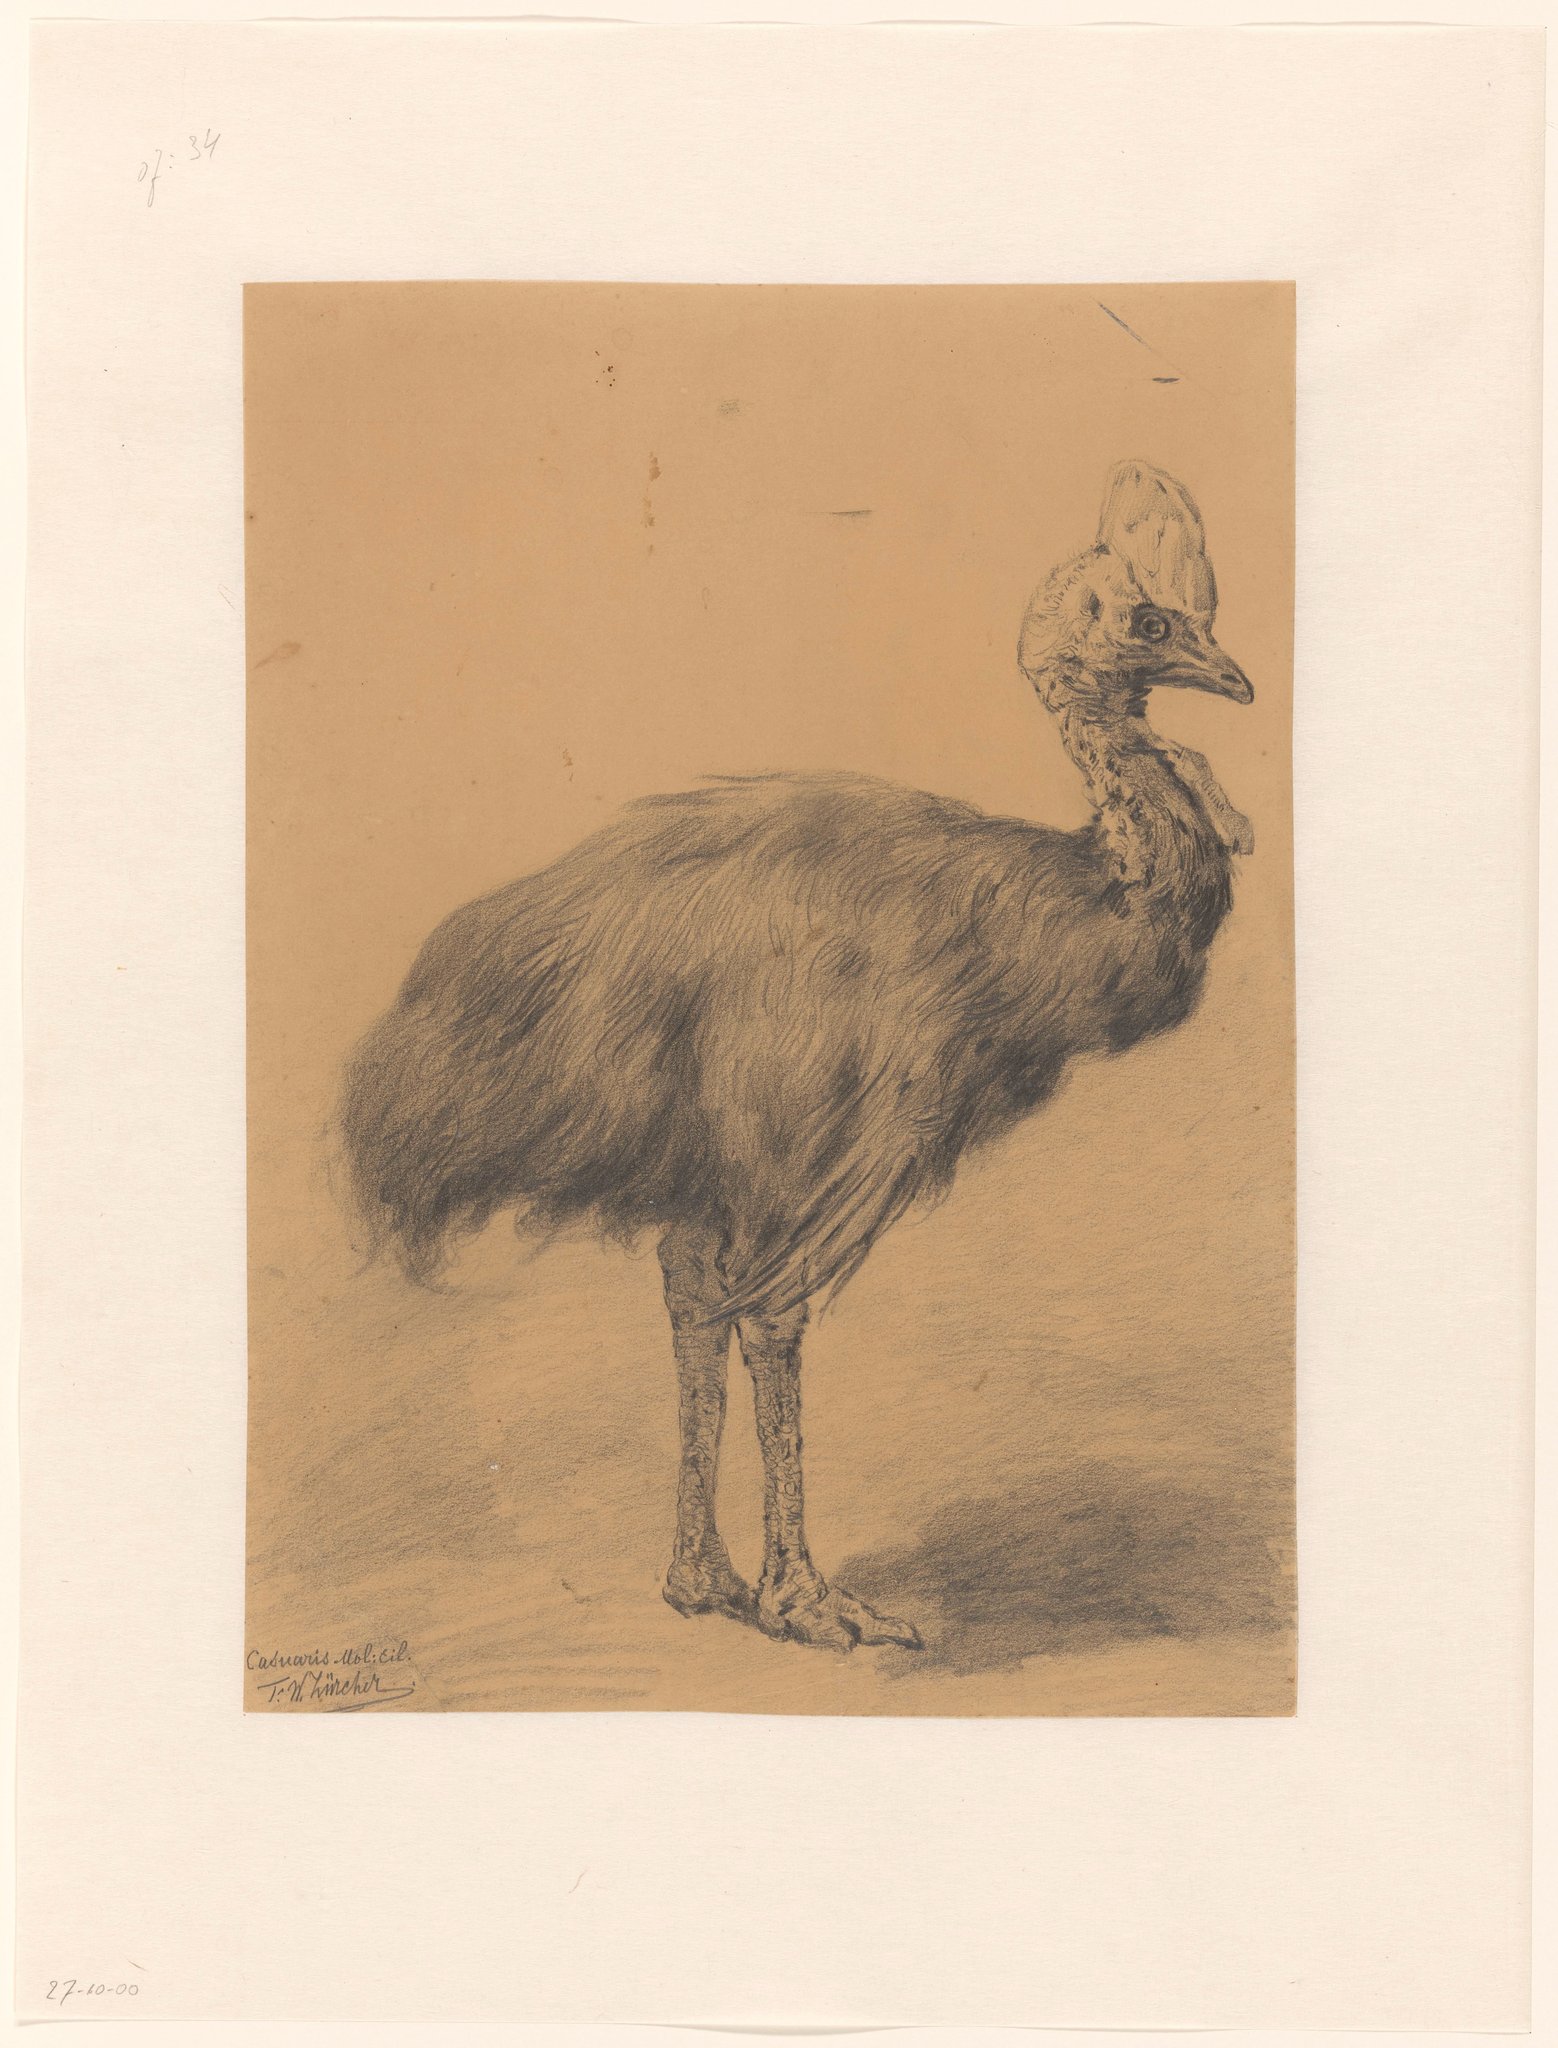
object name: drawing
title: Een Kasuaris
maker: frederik willem zürcher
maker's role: draughtsman, print maker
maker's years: 1835-1894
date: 1845-1894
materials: paper, pencil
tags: walker and runner birds: cassowary